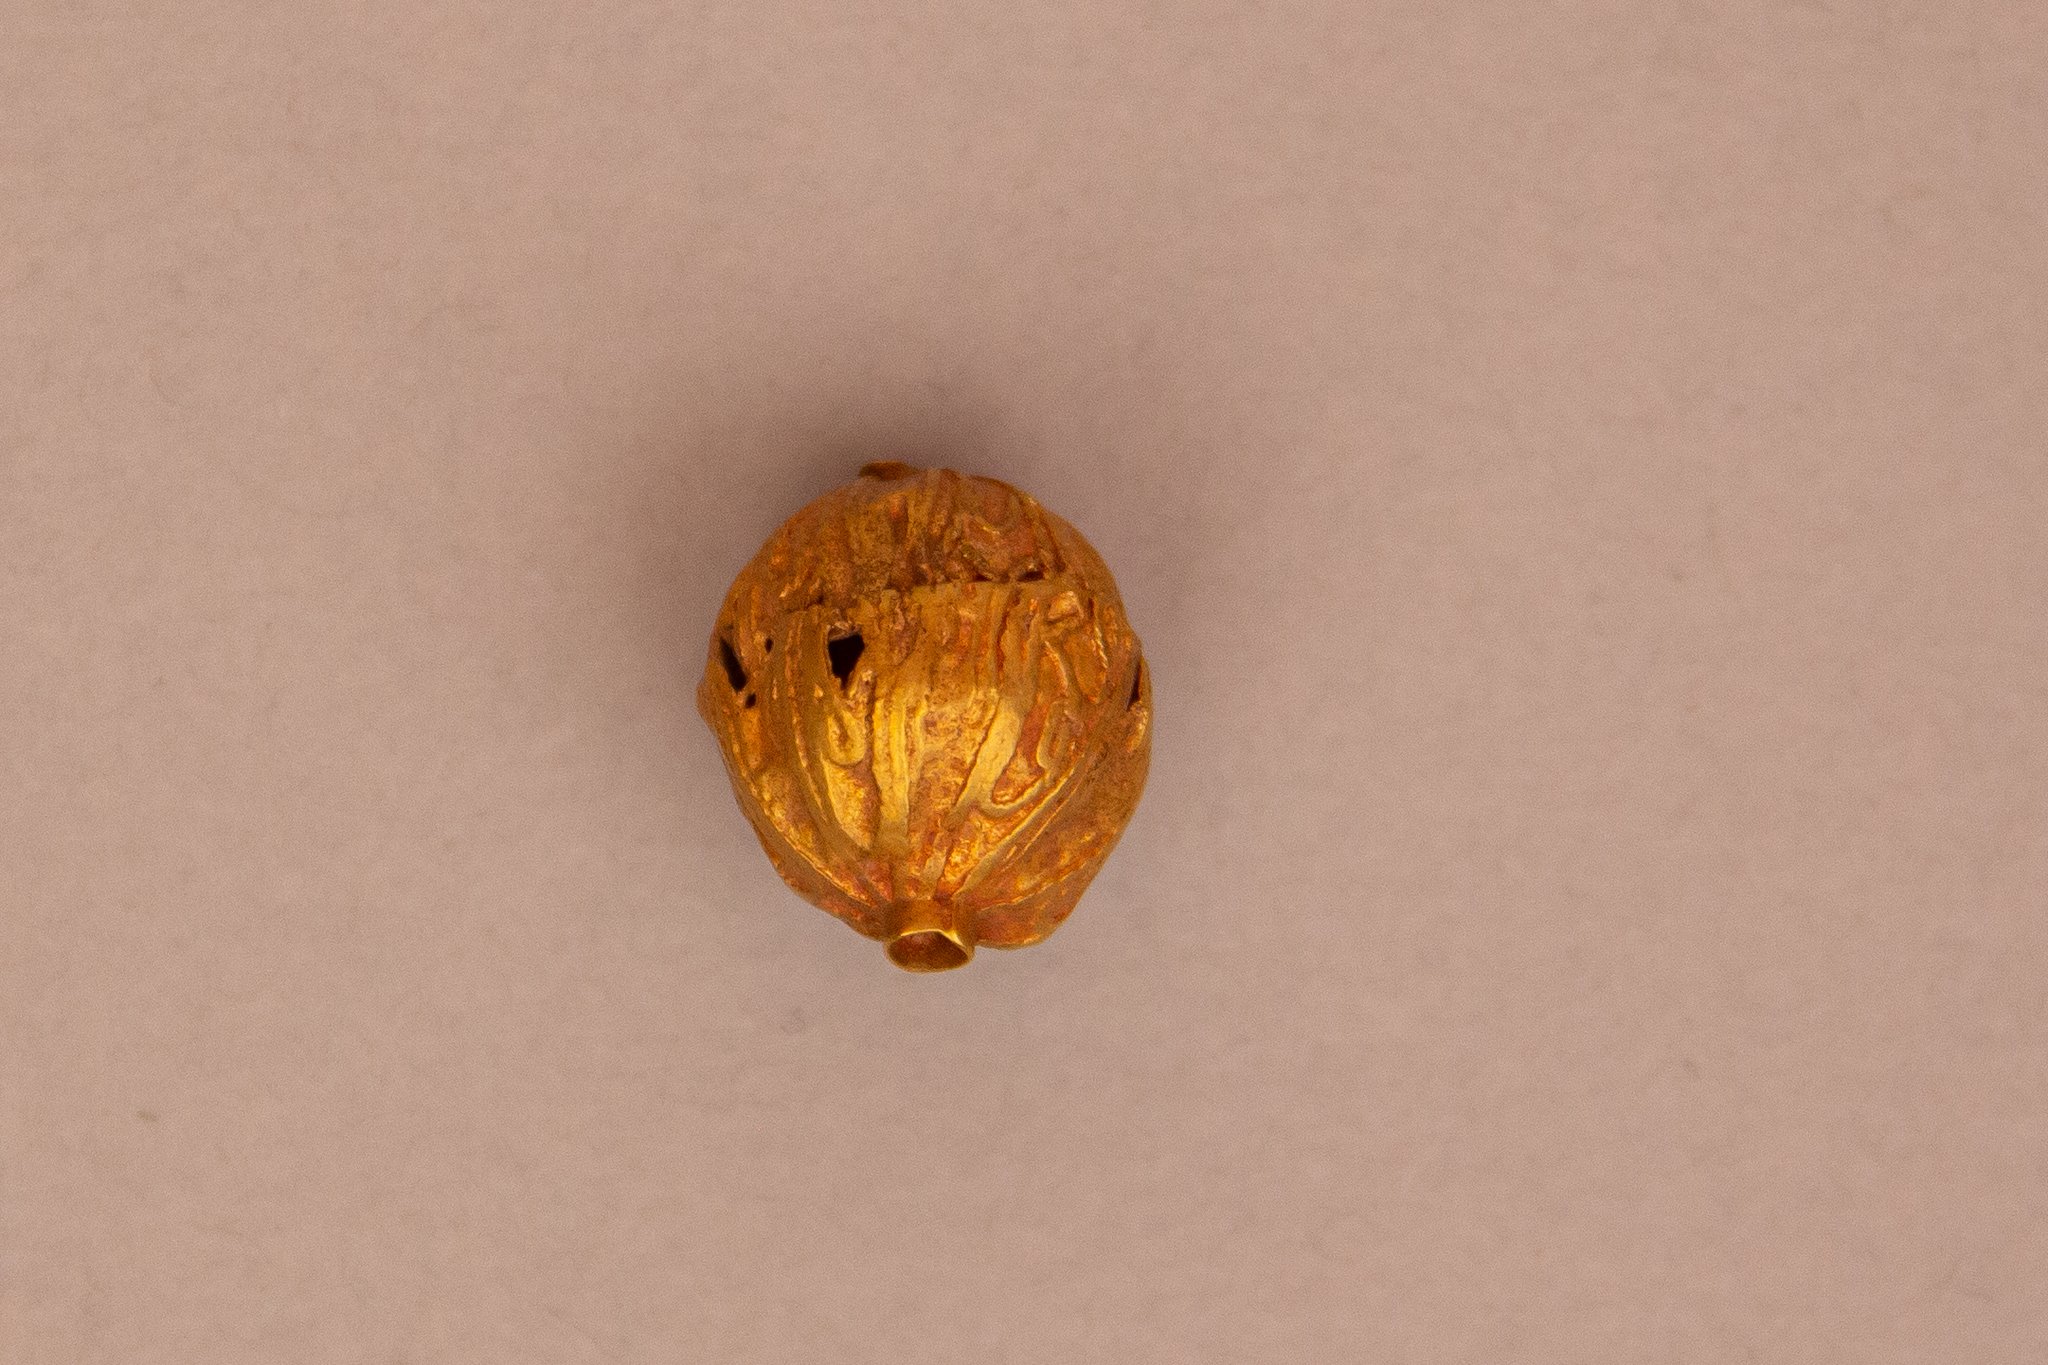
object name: bead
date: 1001-1100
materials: gold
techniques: filigree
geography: egypt or syria